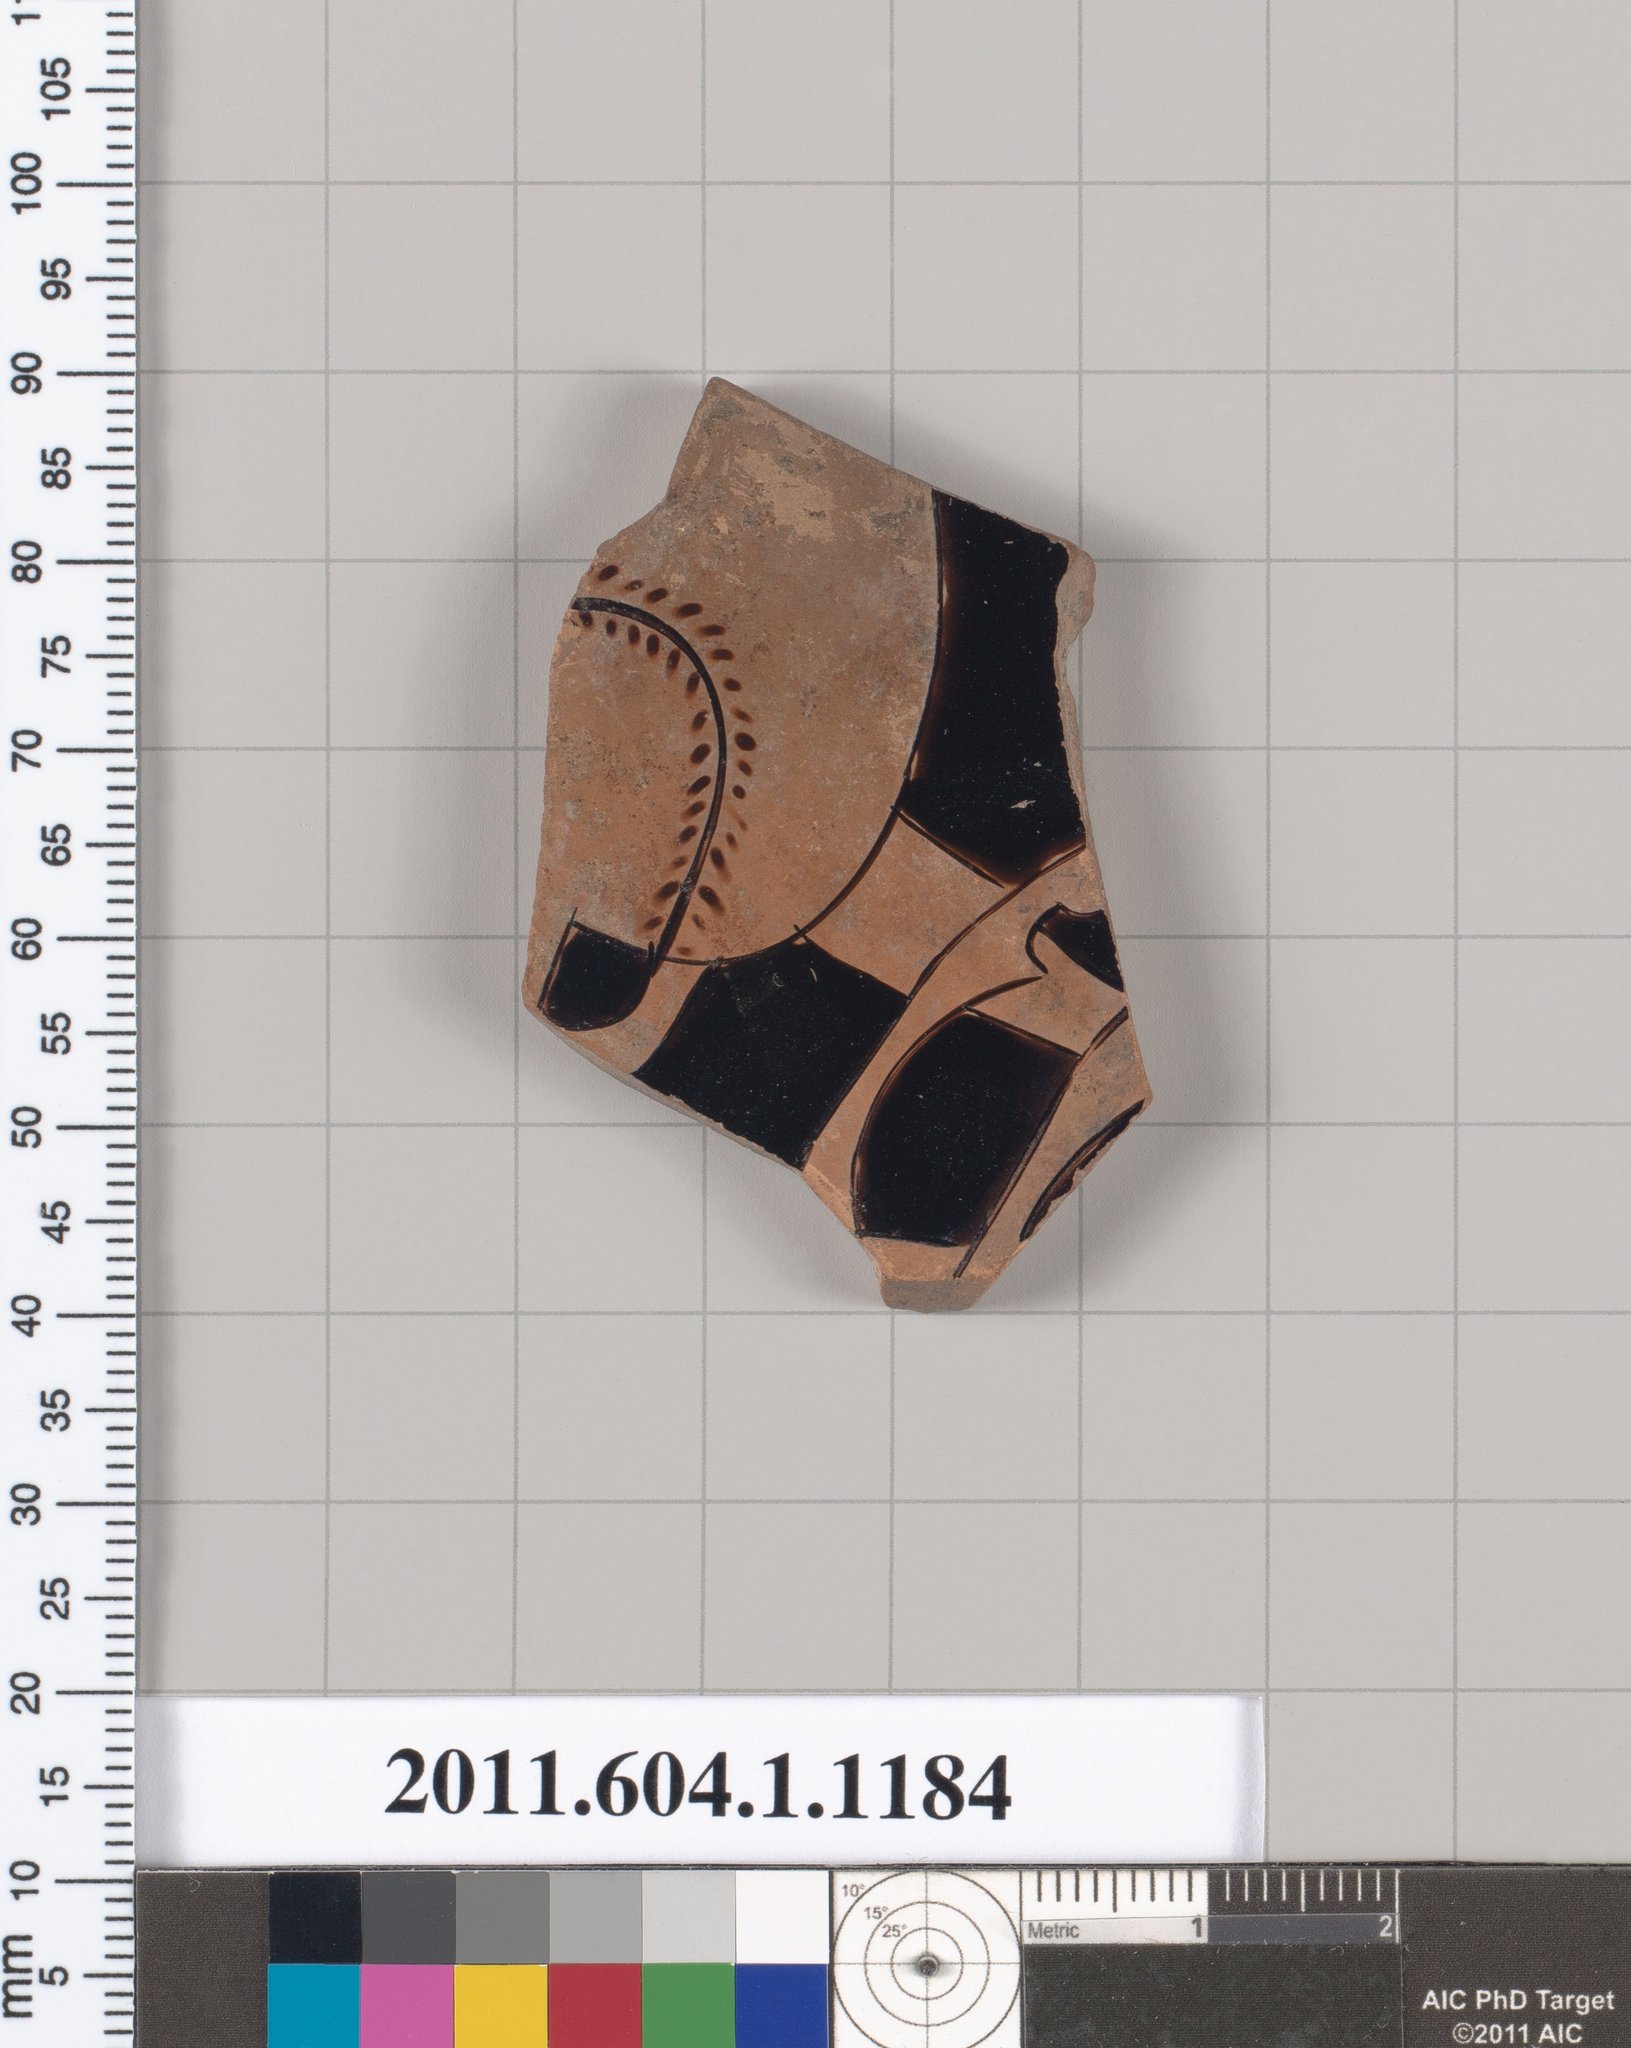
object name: kylix fragment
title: Terracotta fragment of a kylix (drinking cup)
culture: greek, attic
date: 490-480 BCE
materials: terracotta